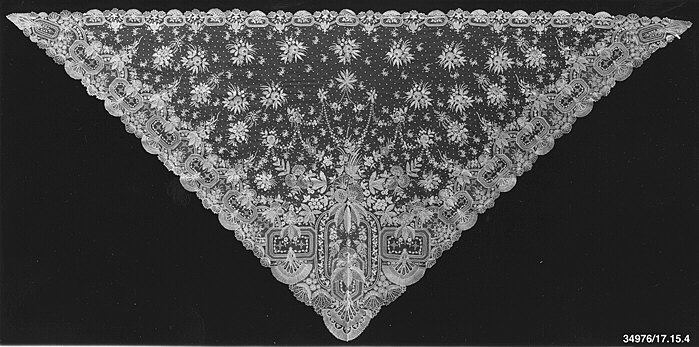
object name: shawl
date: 1860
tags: flowers